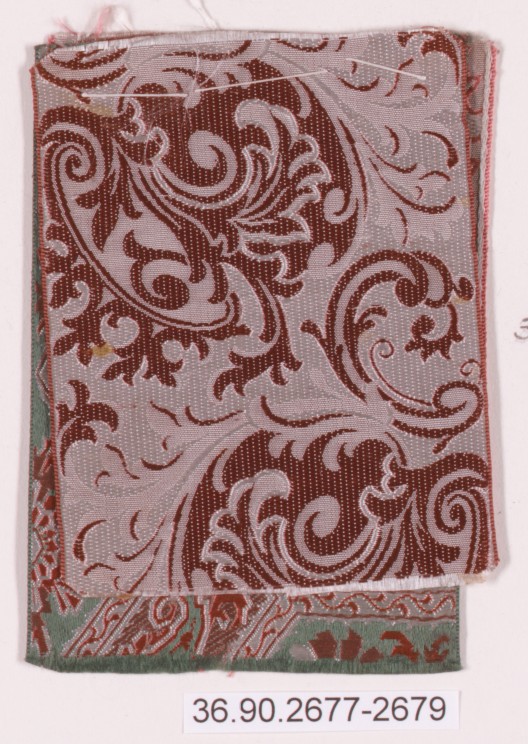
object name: ribbon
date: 1801-1900